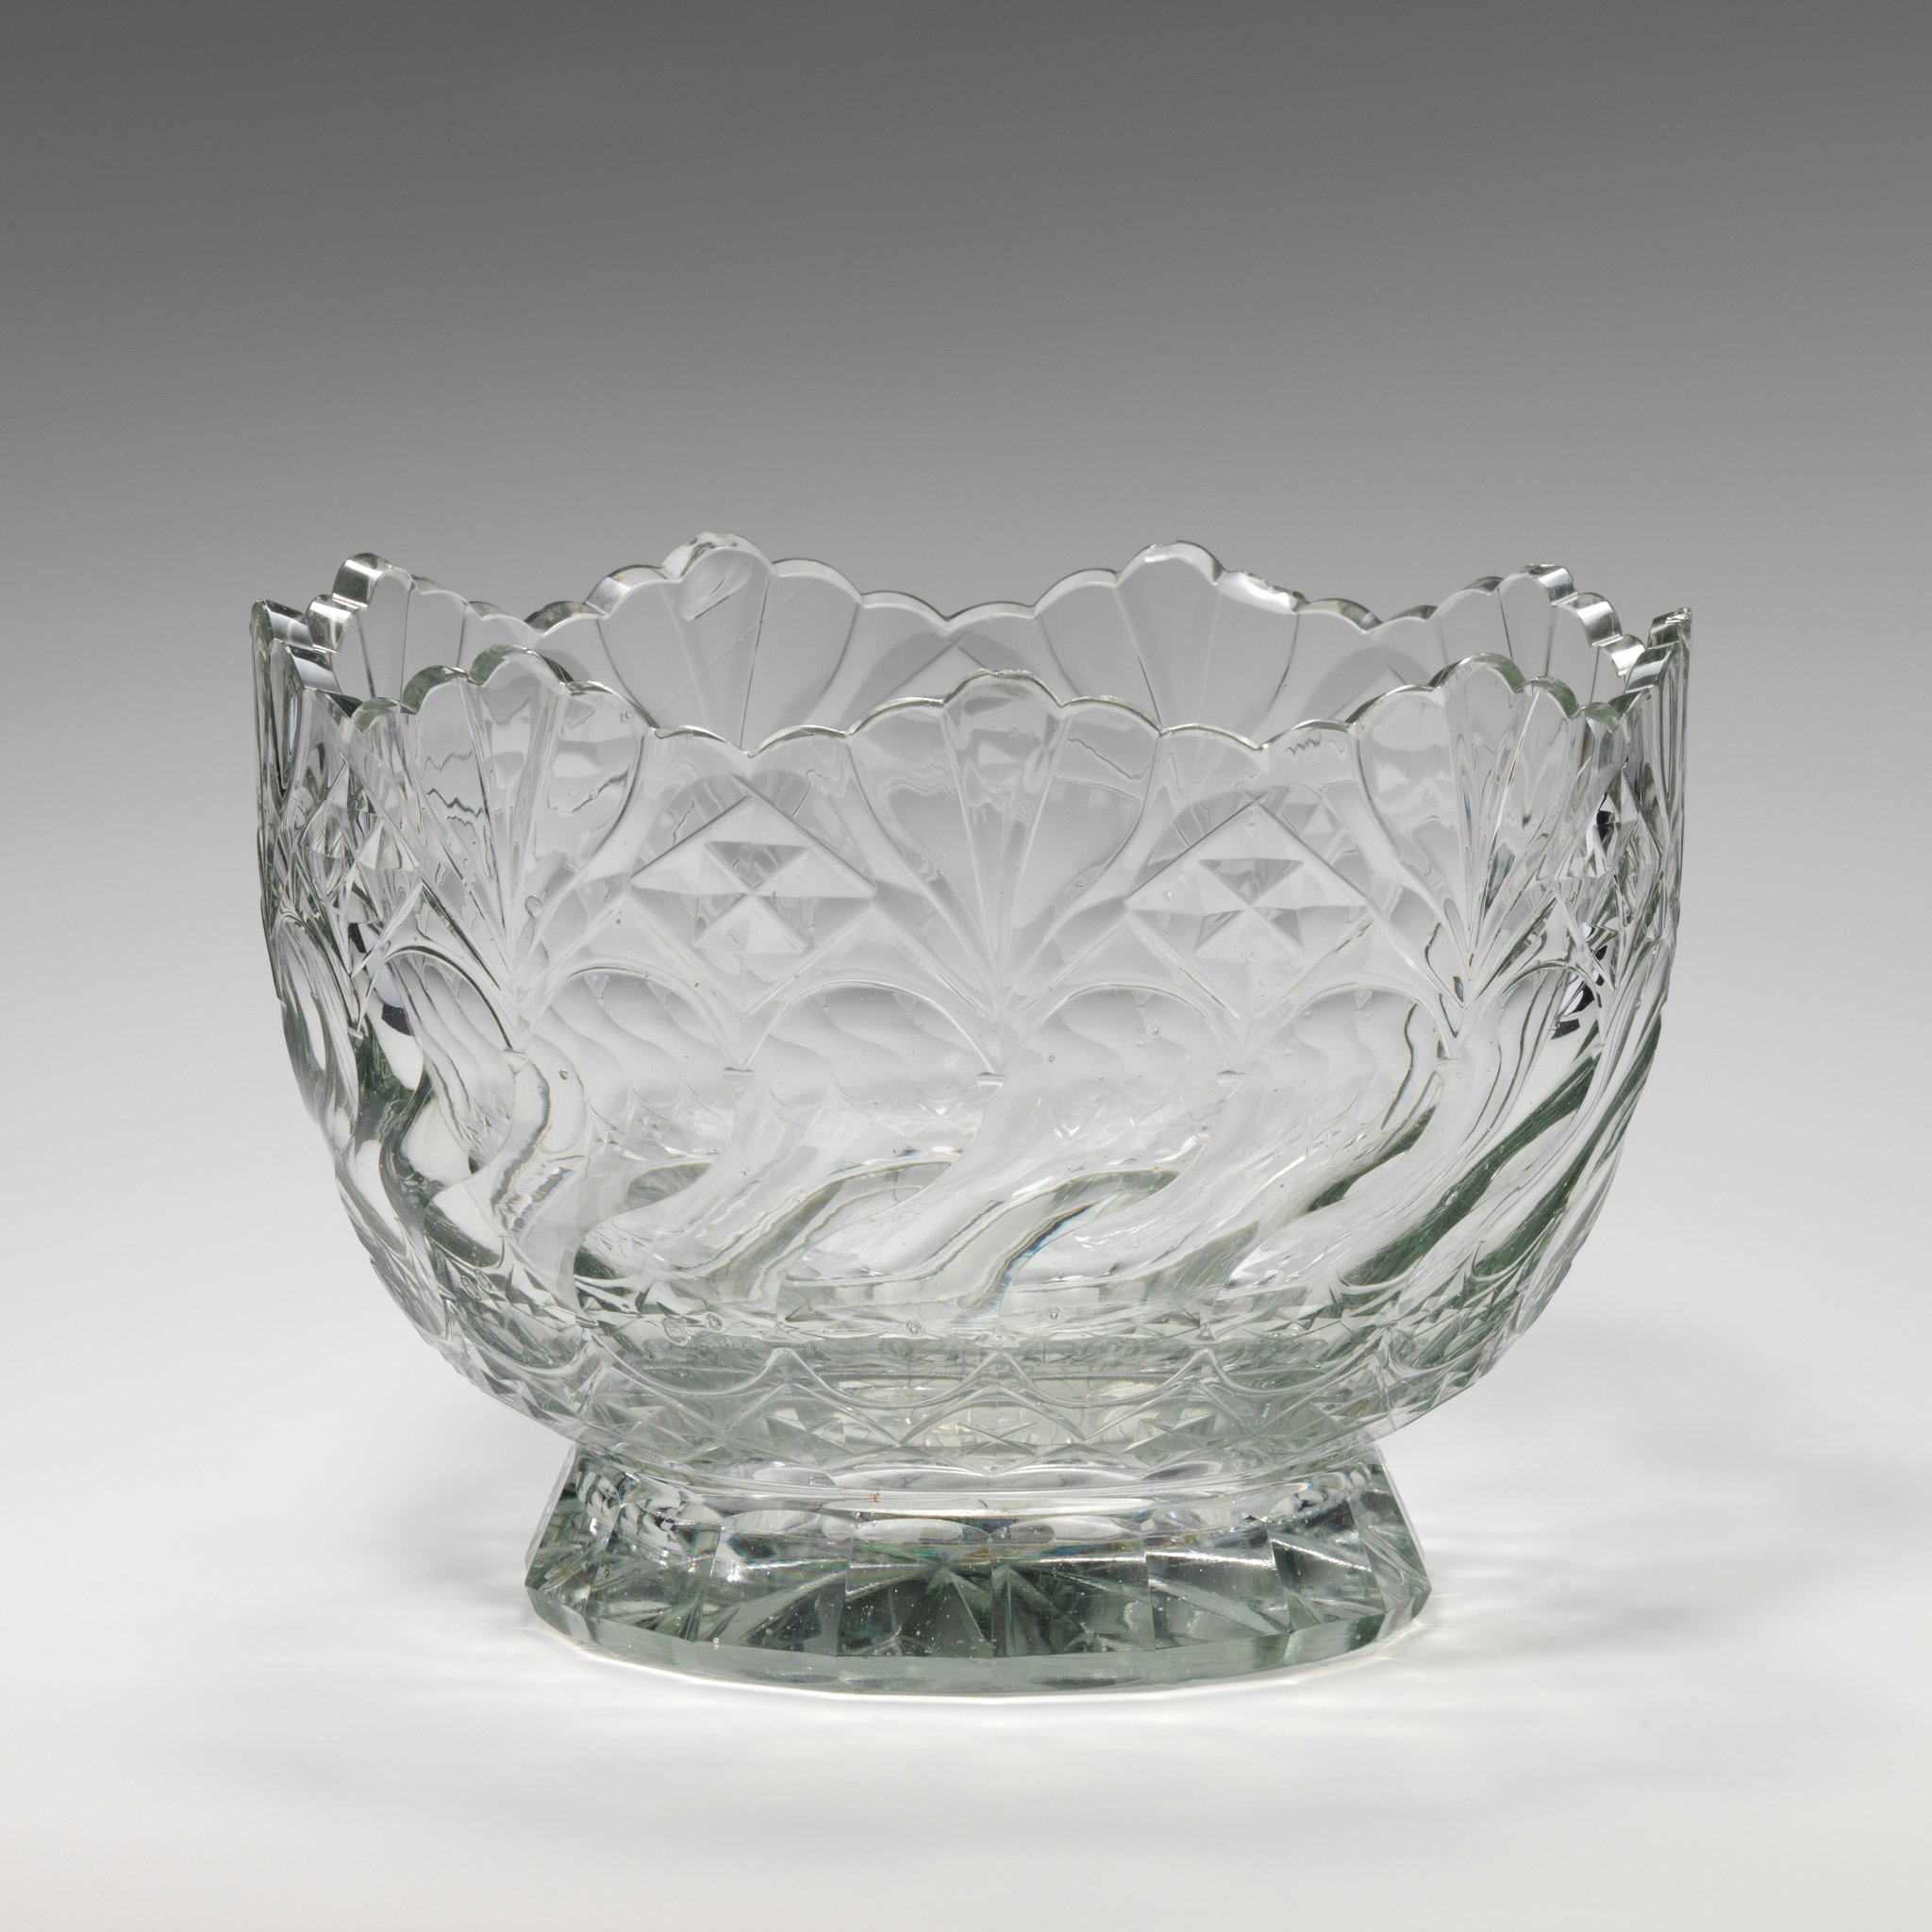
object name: bowl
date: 1767-1833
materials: glass